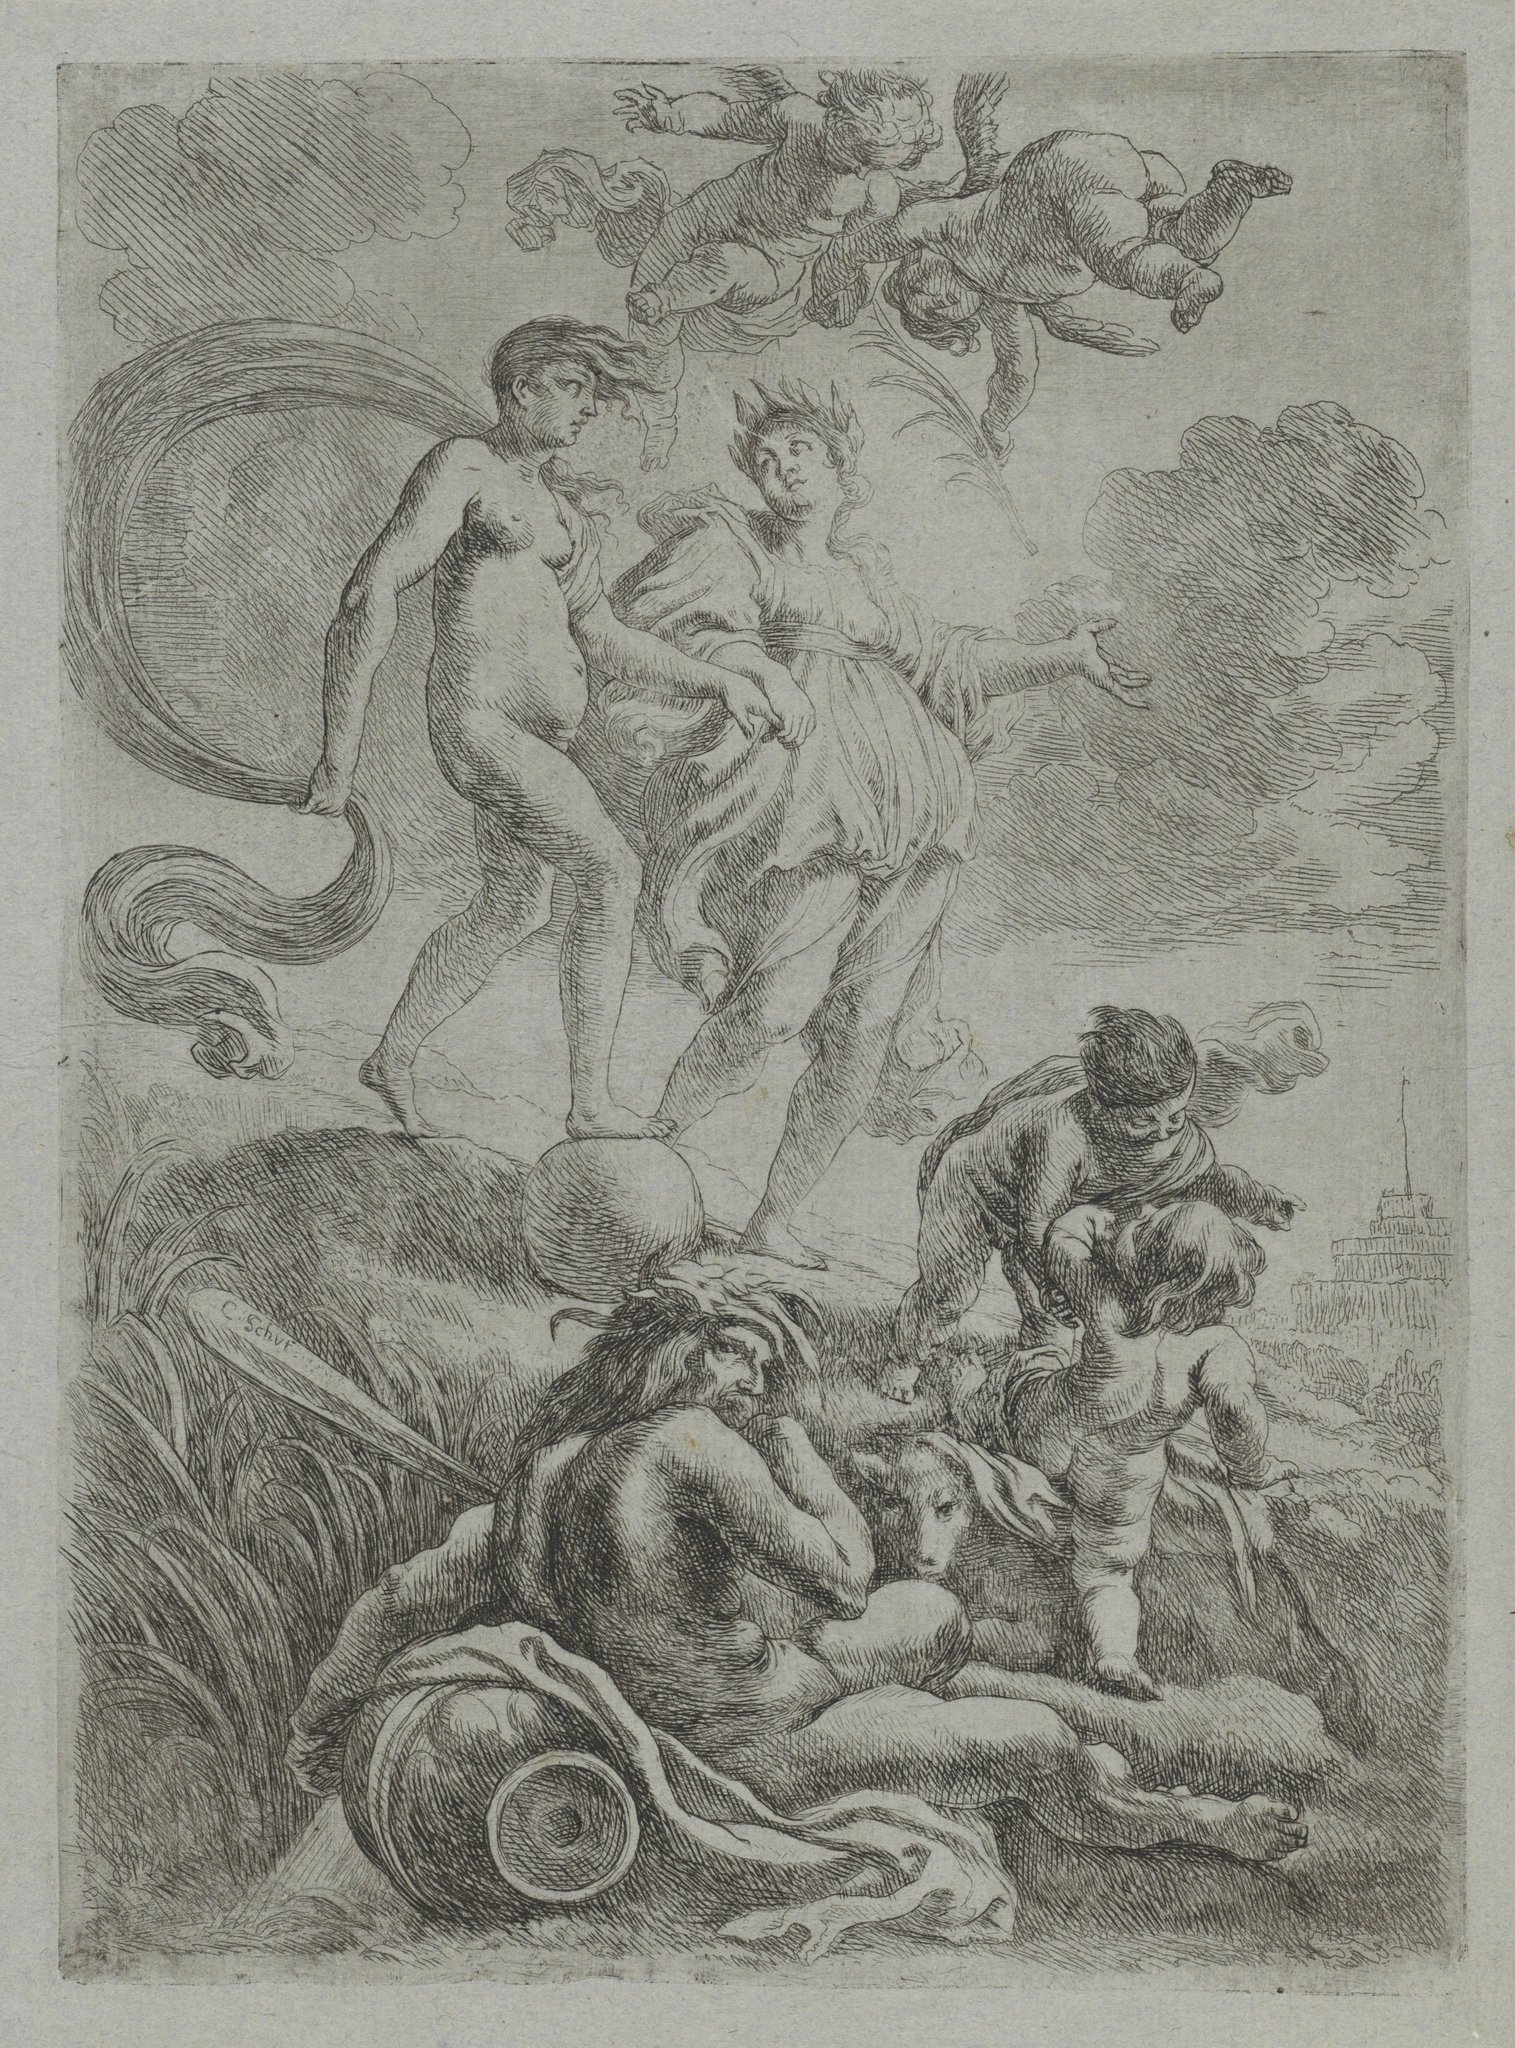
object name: print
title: Geluk en Vrede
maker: cornelis schut (i)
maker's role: draughtsman, print maker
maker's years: 1597-1655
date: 1618-1655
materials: paper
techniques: engraving, etching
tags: symbols, allegories of peace, 'pax'; 'pace' (ripa), river-gods, luck, fortune, lot; 'fato', 'fortuna', 'fortuna aurea', 'fortuna buona', 'fortuna pacifica overo clemente', 'sorte' (ripa)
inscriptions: collector's mark: Lugt 240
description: Vrede leidt de blinde Fortuna bij de hand. Fortuna staat met een voet op een globe. Op de voorgrond ligt een riviergod. Daarachter en in de lucht spelen putti.